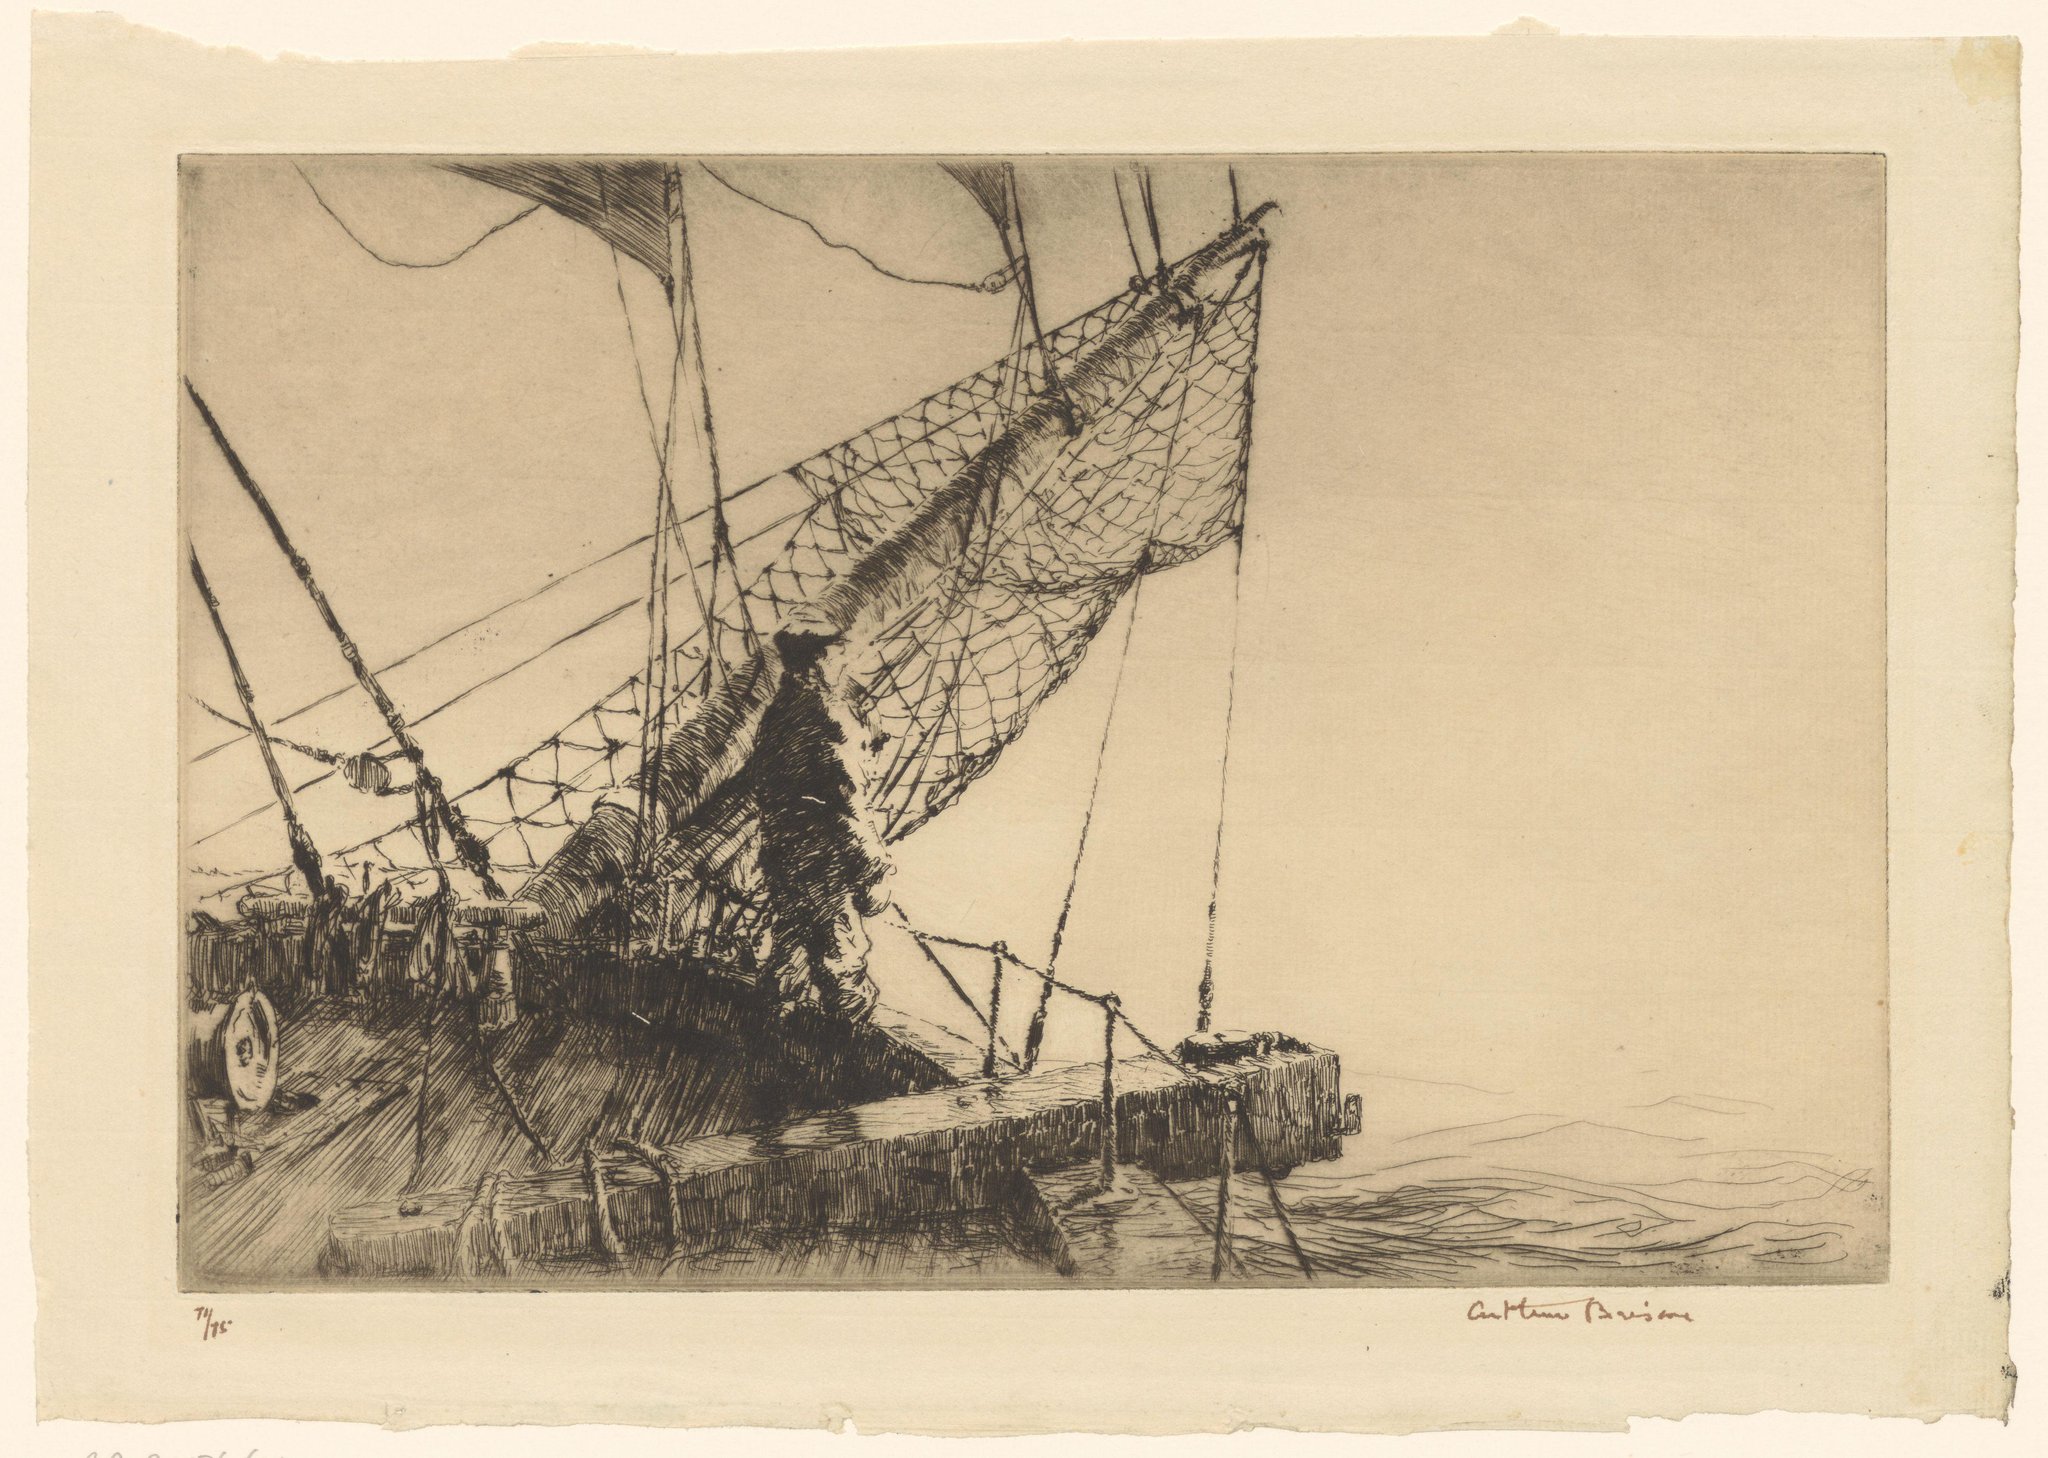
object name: print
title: The Look-out, Sunrise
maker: arthur john trevor briscoe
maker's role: print maker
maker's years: 1873-1943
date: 1925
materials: paper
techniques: drypoint, etching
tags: sailing-ship, sailing-boat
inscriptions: collector's mark: Lugt 2228